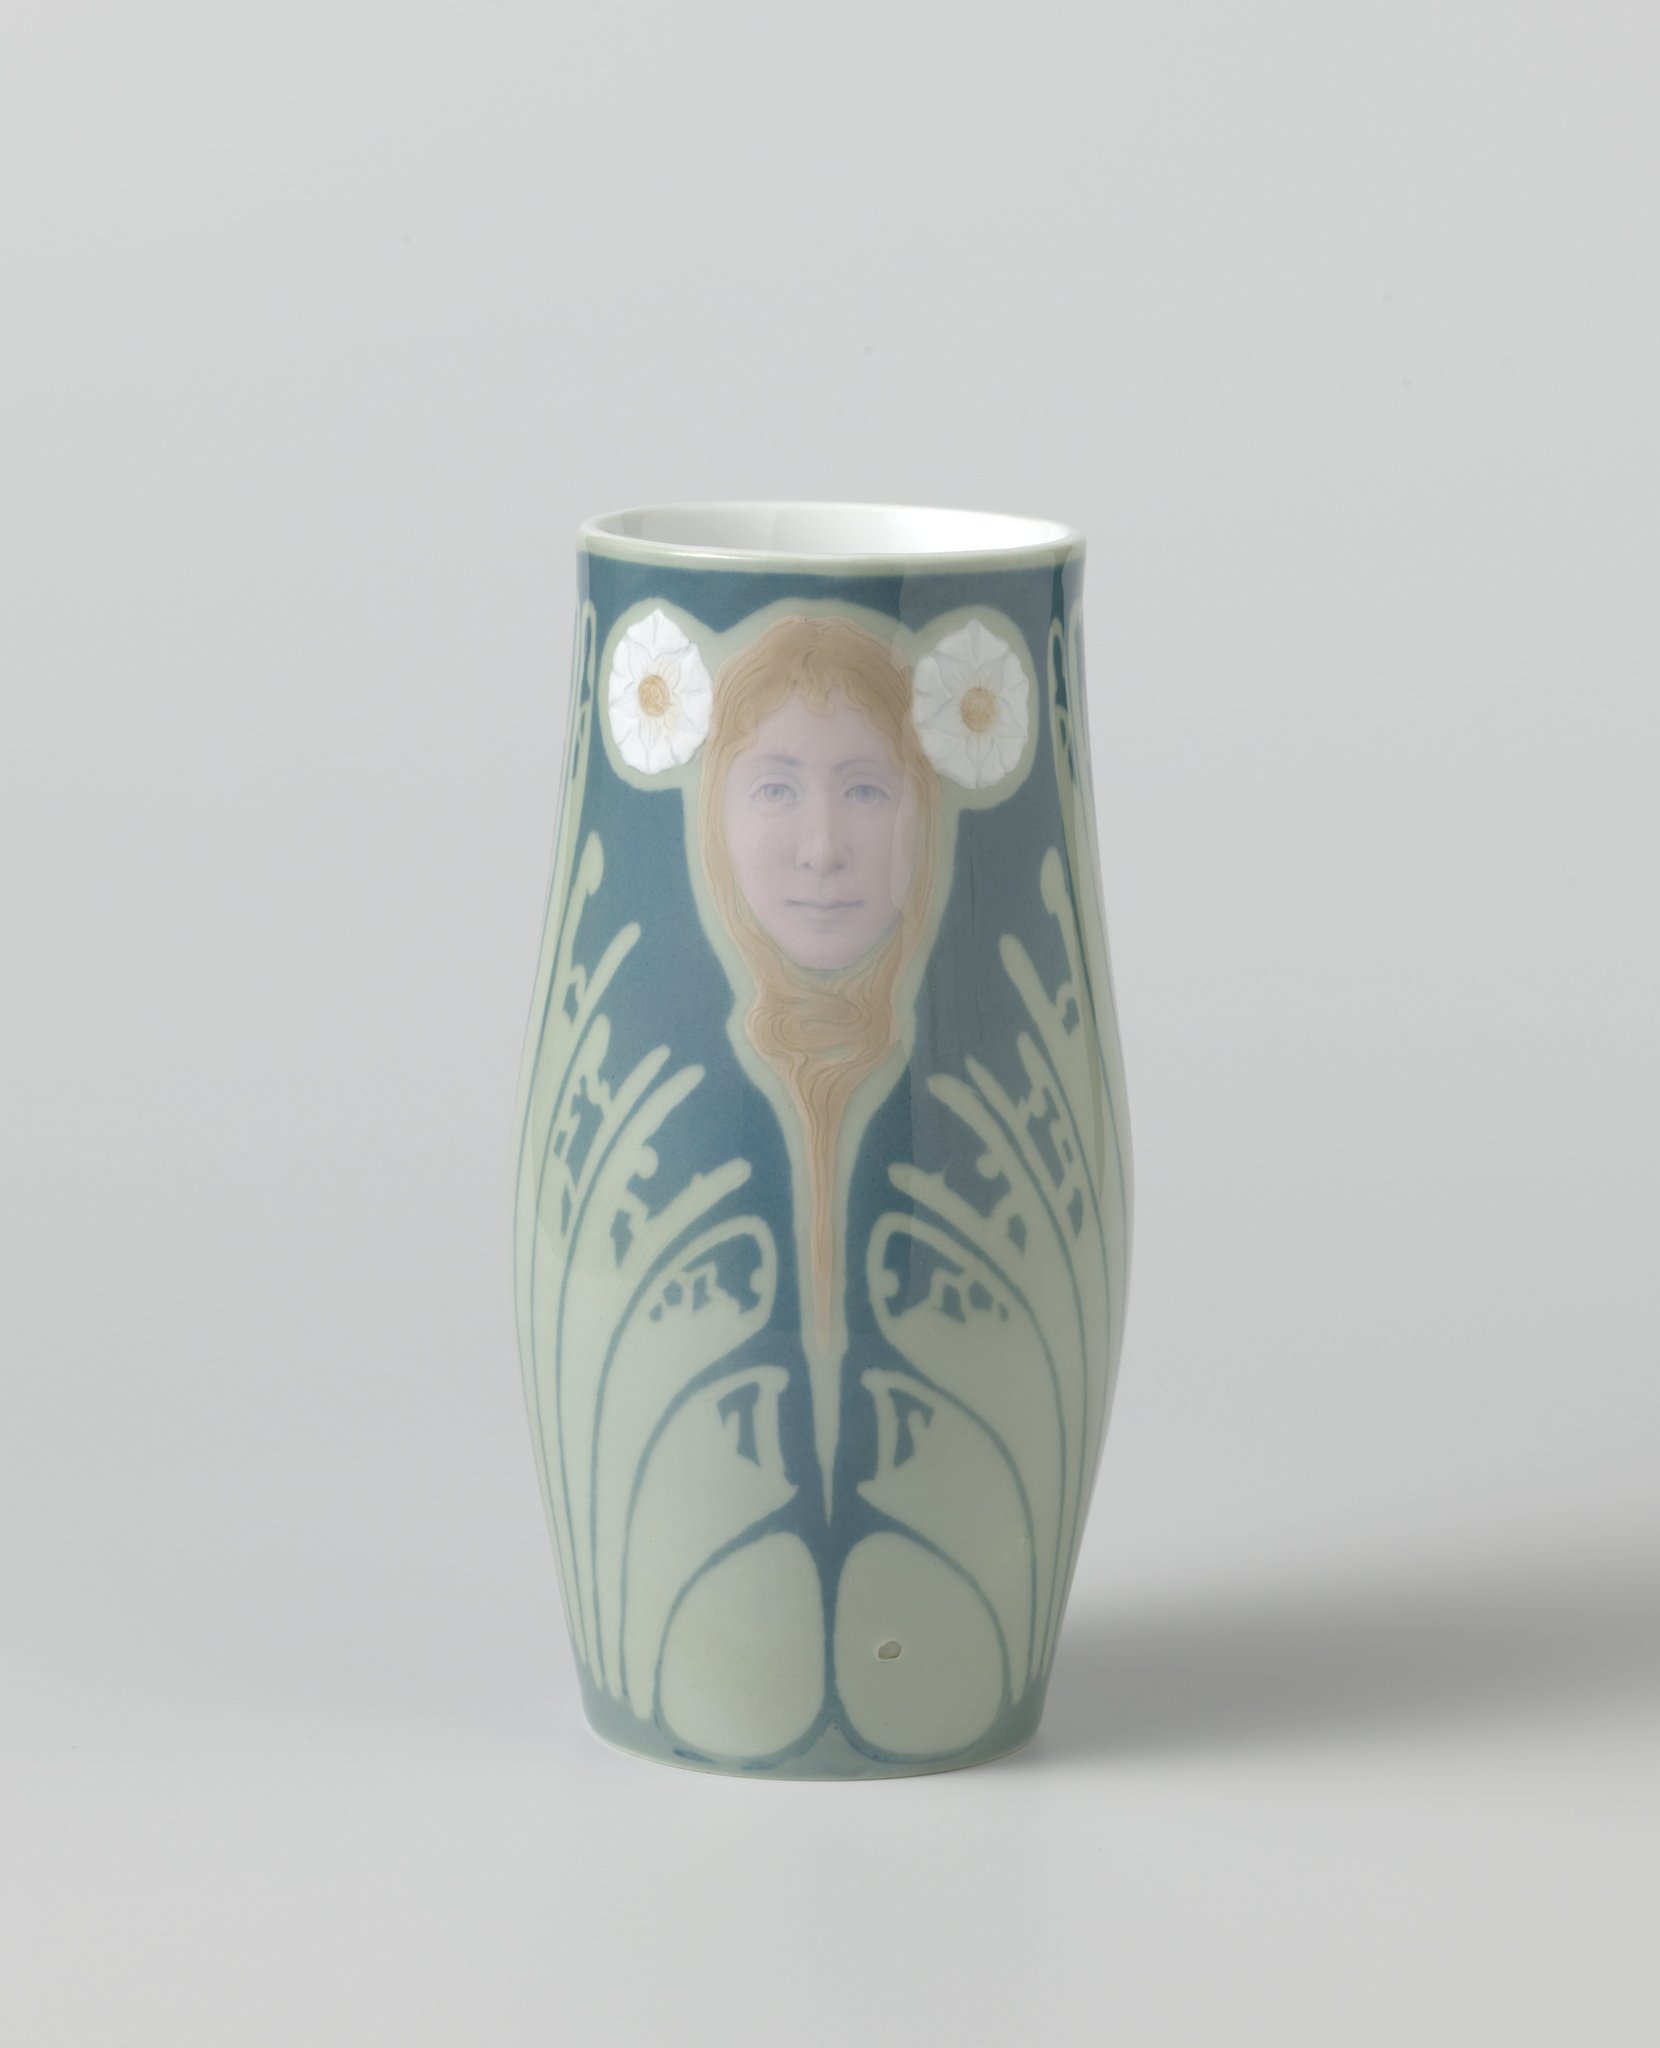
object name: decoratief object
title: Vaas, veelkleurig beschilderd met vrouwenkoppen en een geabstraheerd vegetatief motief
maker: rudolf hentschel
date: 1902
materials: porcelain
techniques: pâte sur pâte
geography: meissen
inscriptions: check stamp: ‘133’, model number: ‘T.120’, factory mark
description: Vase. Porcelain decorated in pâte-sur-pâte technique. Meissen, made by Königlich Sächsische Porzellanmanufaktur, c. 1902. The design of the decoration attributed to Rudolf Hentschel.